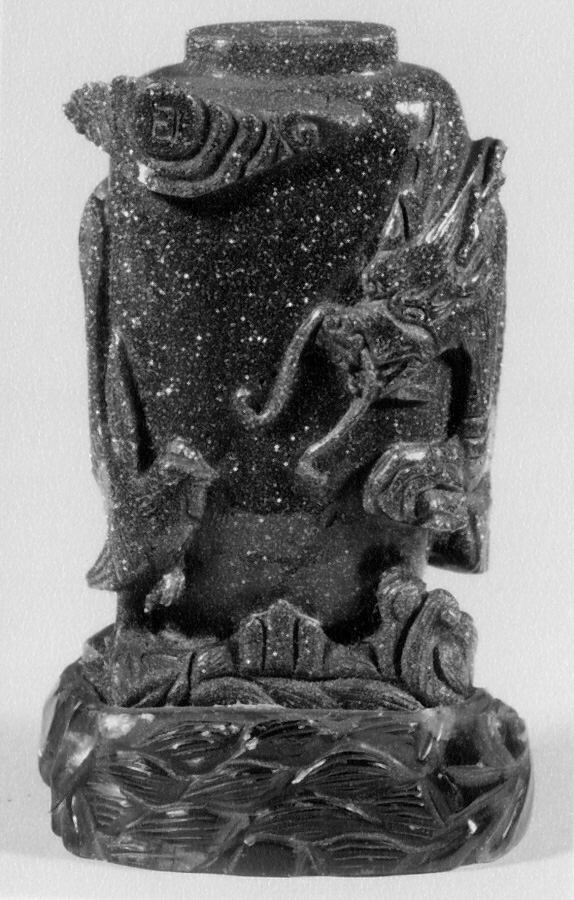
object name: snuff bottle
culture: chinese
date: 1801-1900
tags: birds,dragons